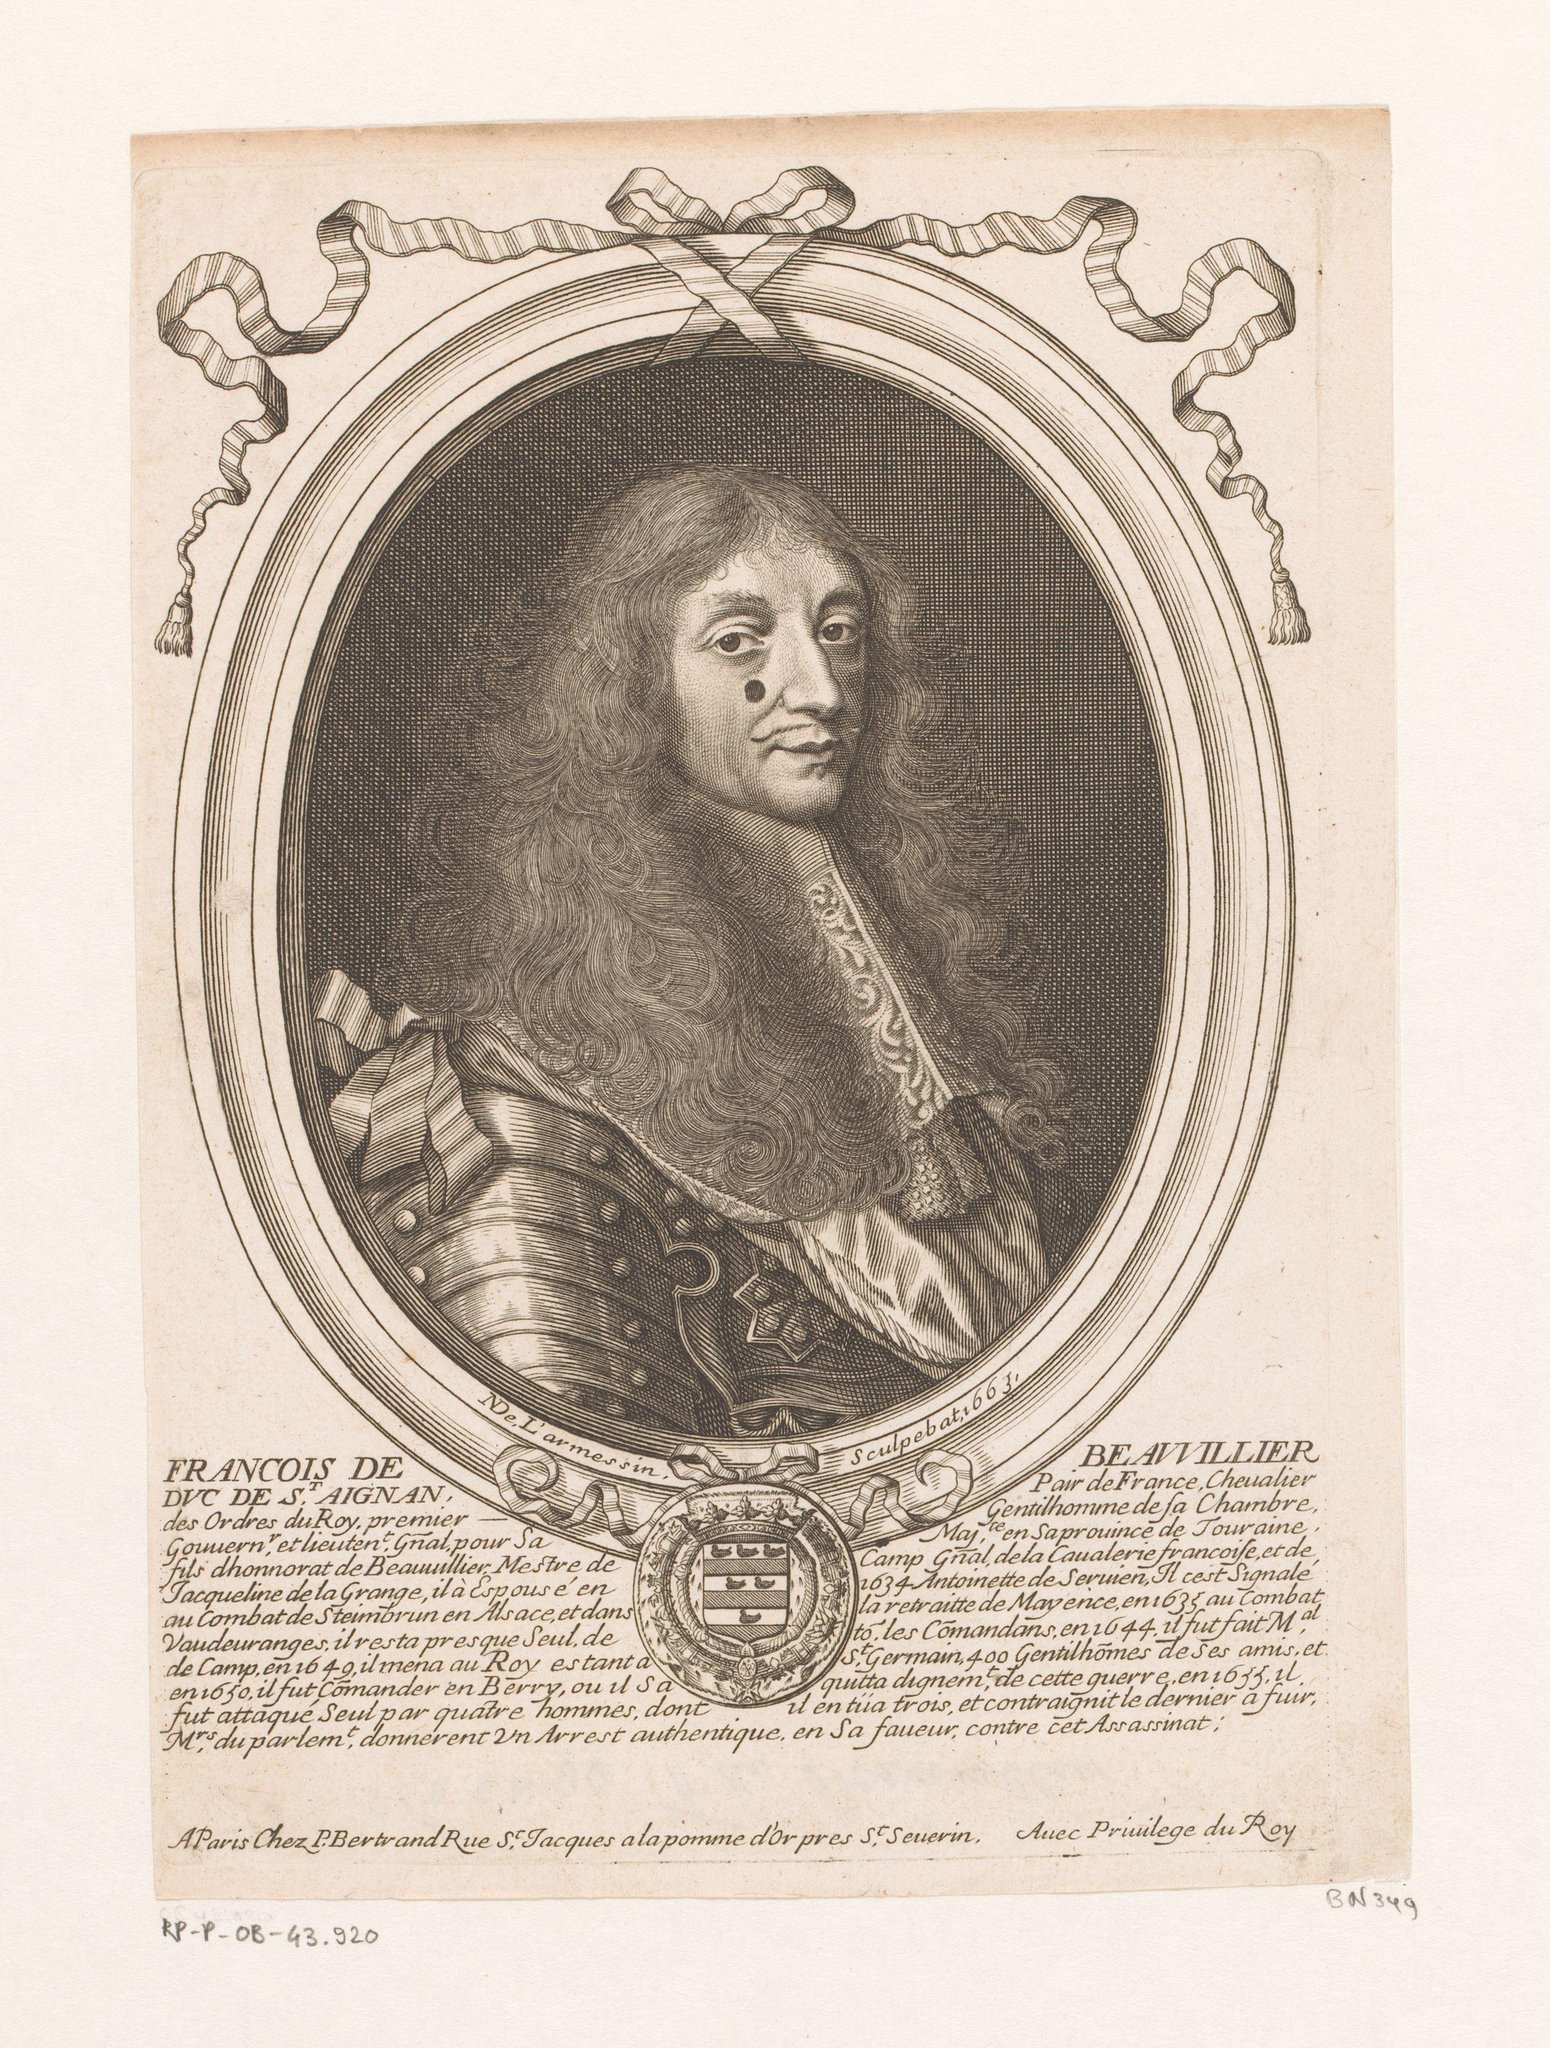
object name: print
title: Portret van François de Beauvilliers duc de Saint-Aignan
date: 1663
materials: paper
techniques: engraving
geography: france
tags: paris, françois de beauvilliers de saint-aignan, historical persons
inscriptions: collector's mark: Lugt 2228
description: Maakt deel uit van een grootschalige serie met portretten van prominente figuren. Binnen de serie bevindt zich een sectie getiteld 'Les Augustes Représentations De tous les Roys De France depuis Pharamond Iusqu'à Louys XIIII'. De serie werd respectievelijk uitgegeven door Pierre Bertrand, door zijn weduwe en door De Larmessin zelf.